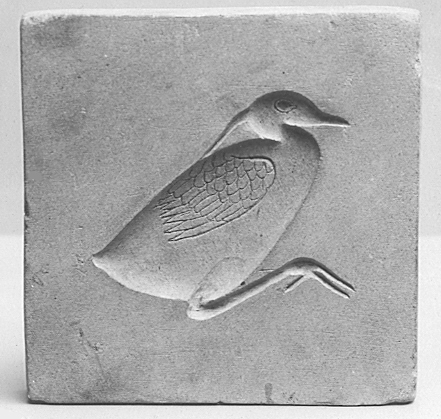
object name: mold, bird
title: A Mold for Metalwork Depicting a Bird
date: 304-30 BCE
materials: limestone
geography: egypt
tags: birds